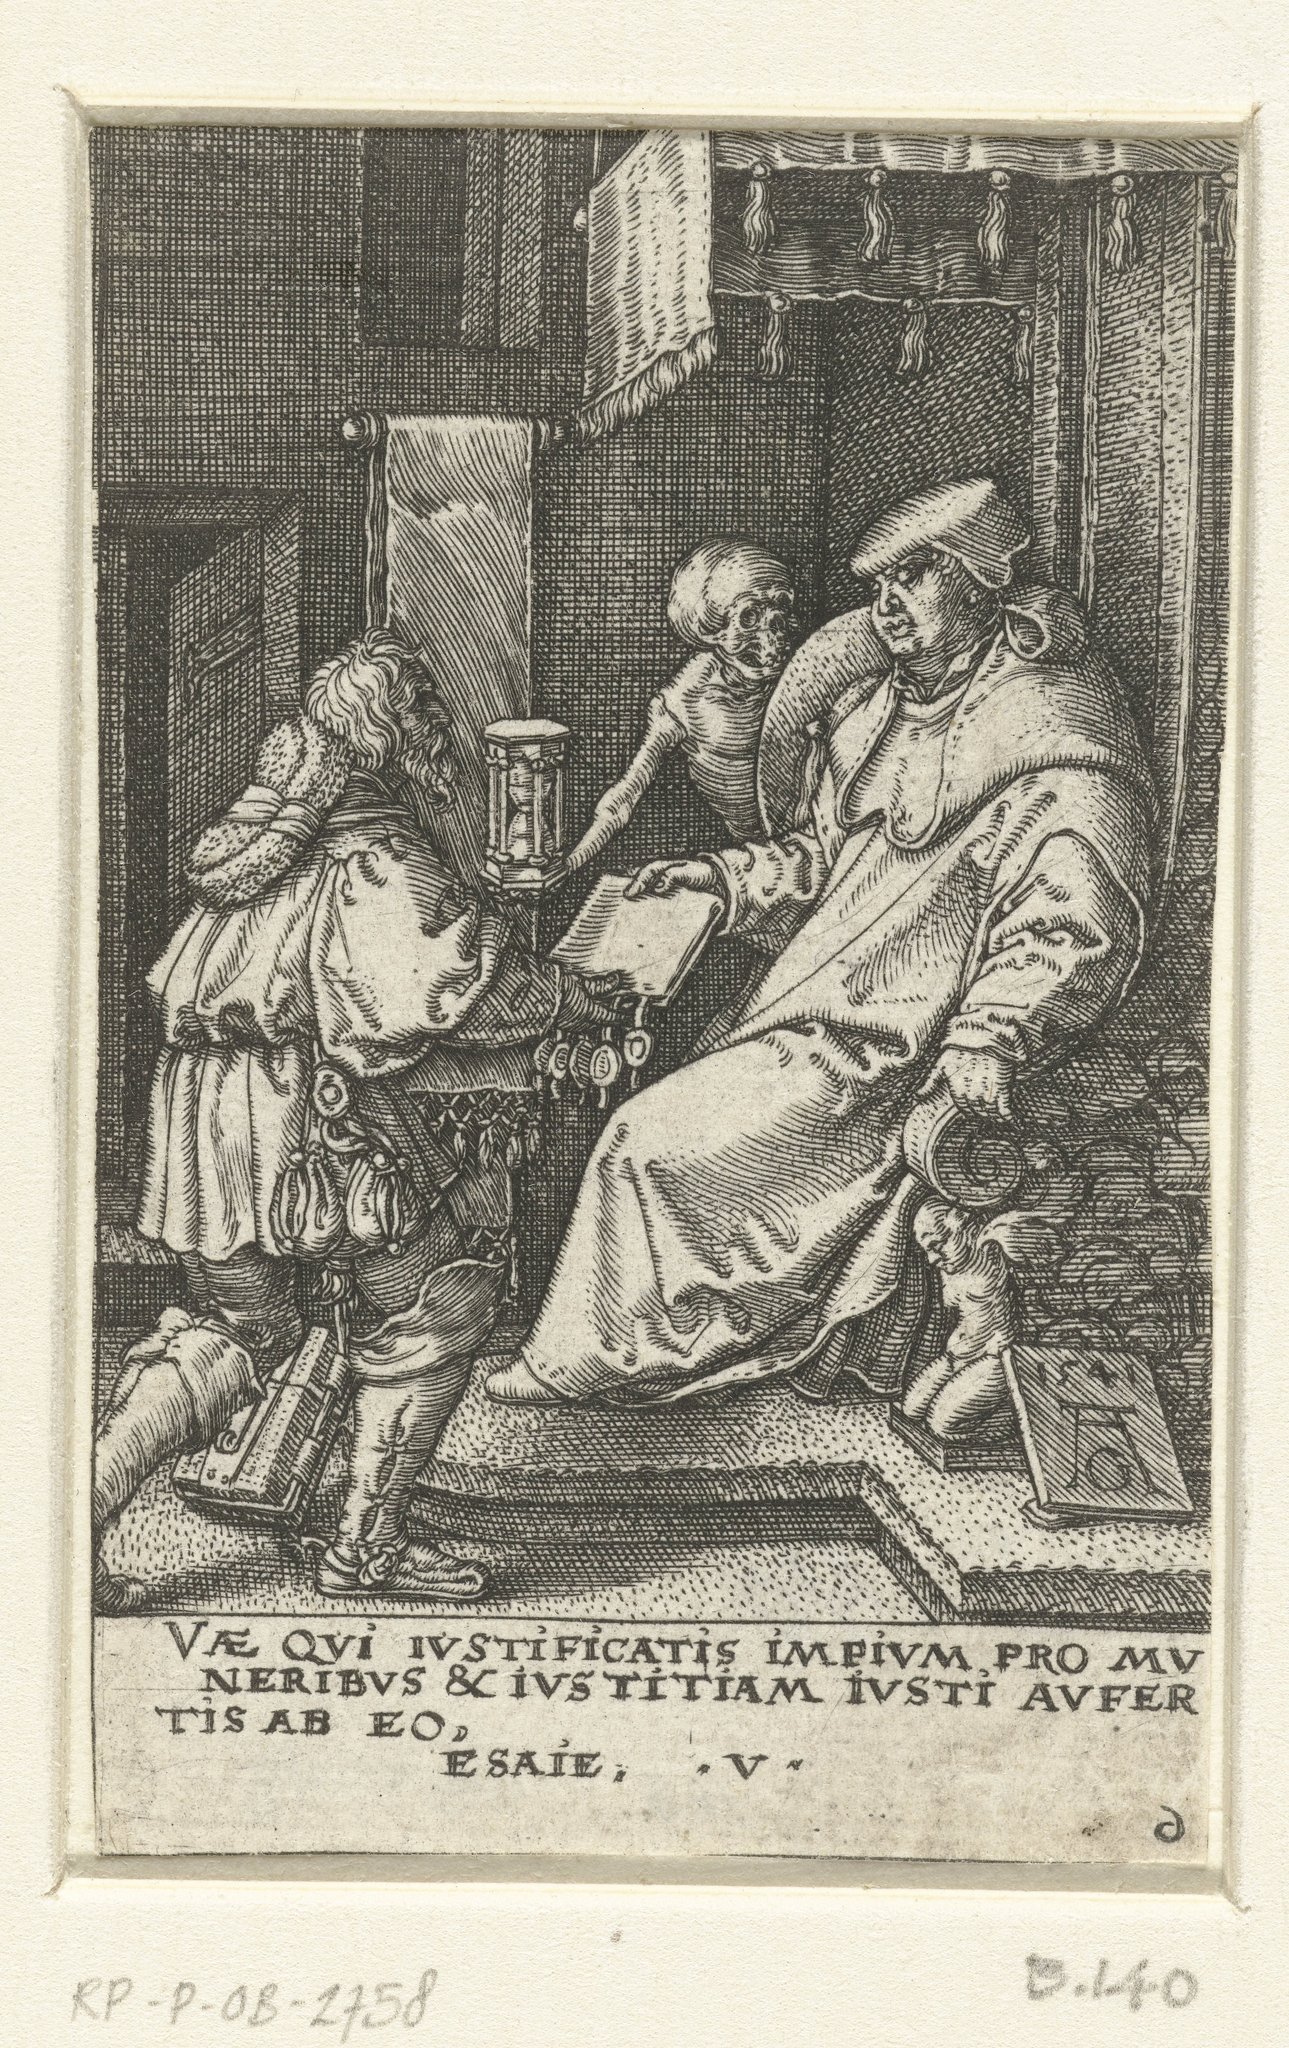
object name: print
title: Macht van de Dood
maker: heinrich aldegrever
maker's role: draughtsman, print maker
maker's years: 1502-1561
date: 1541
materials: paper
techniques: engraving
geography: germany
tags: death as skeleton, cardinal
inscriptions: number: ‘104’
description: Een kardinaal, zittend op een zetel, overhandigt een geschrift met zegels aan de man voor hem. De Dood, met een zandloper in de hand, staat naast hem. Onder de voorstelling een vierregelige tekst in het Latijn. Zesde prent uit een serie van acht over zonde en dood.